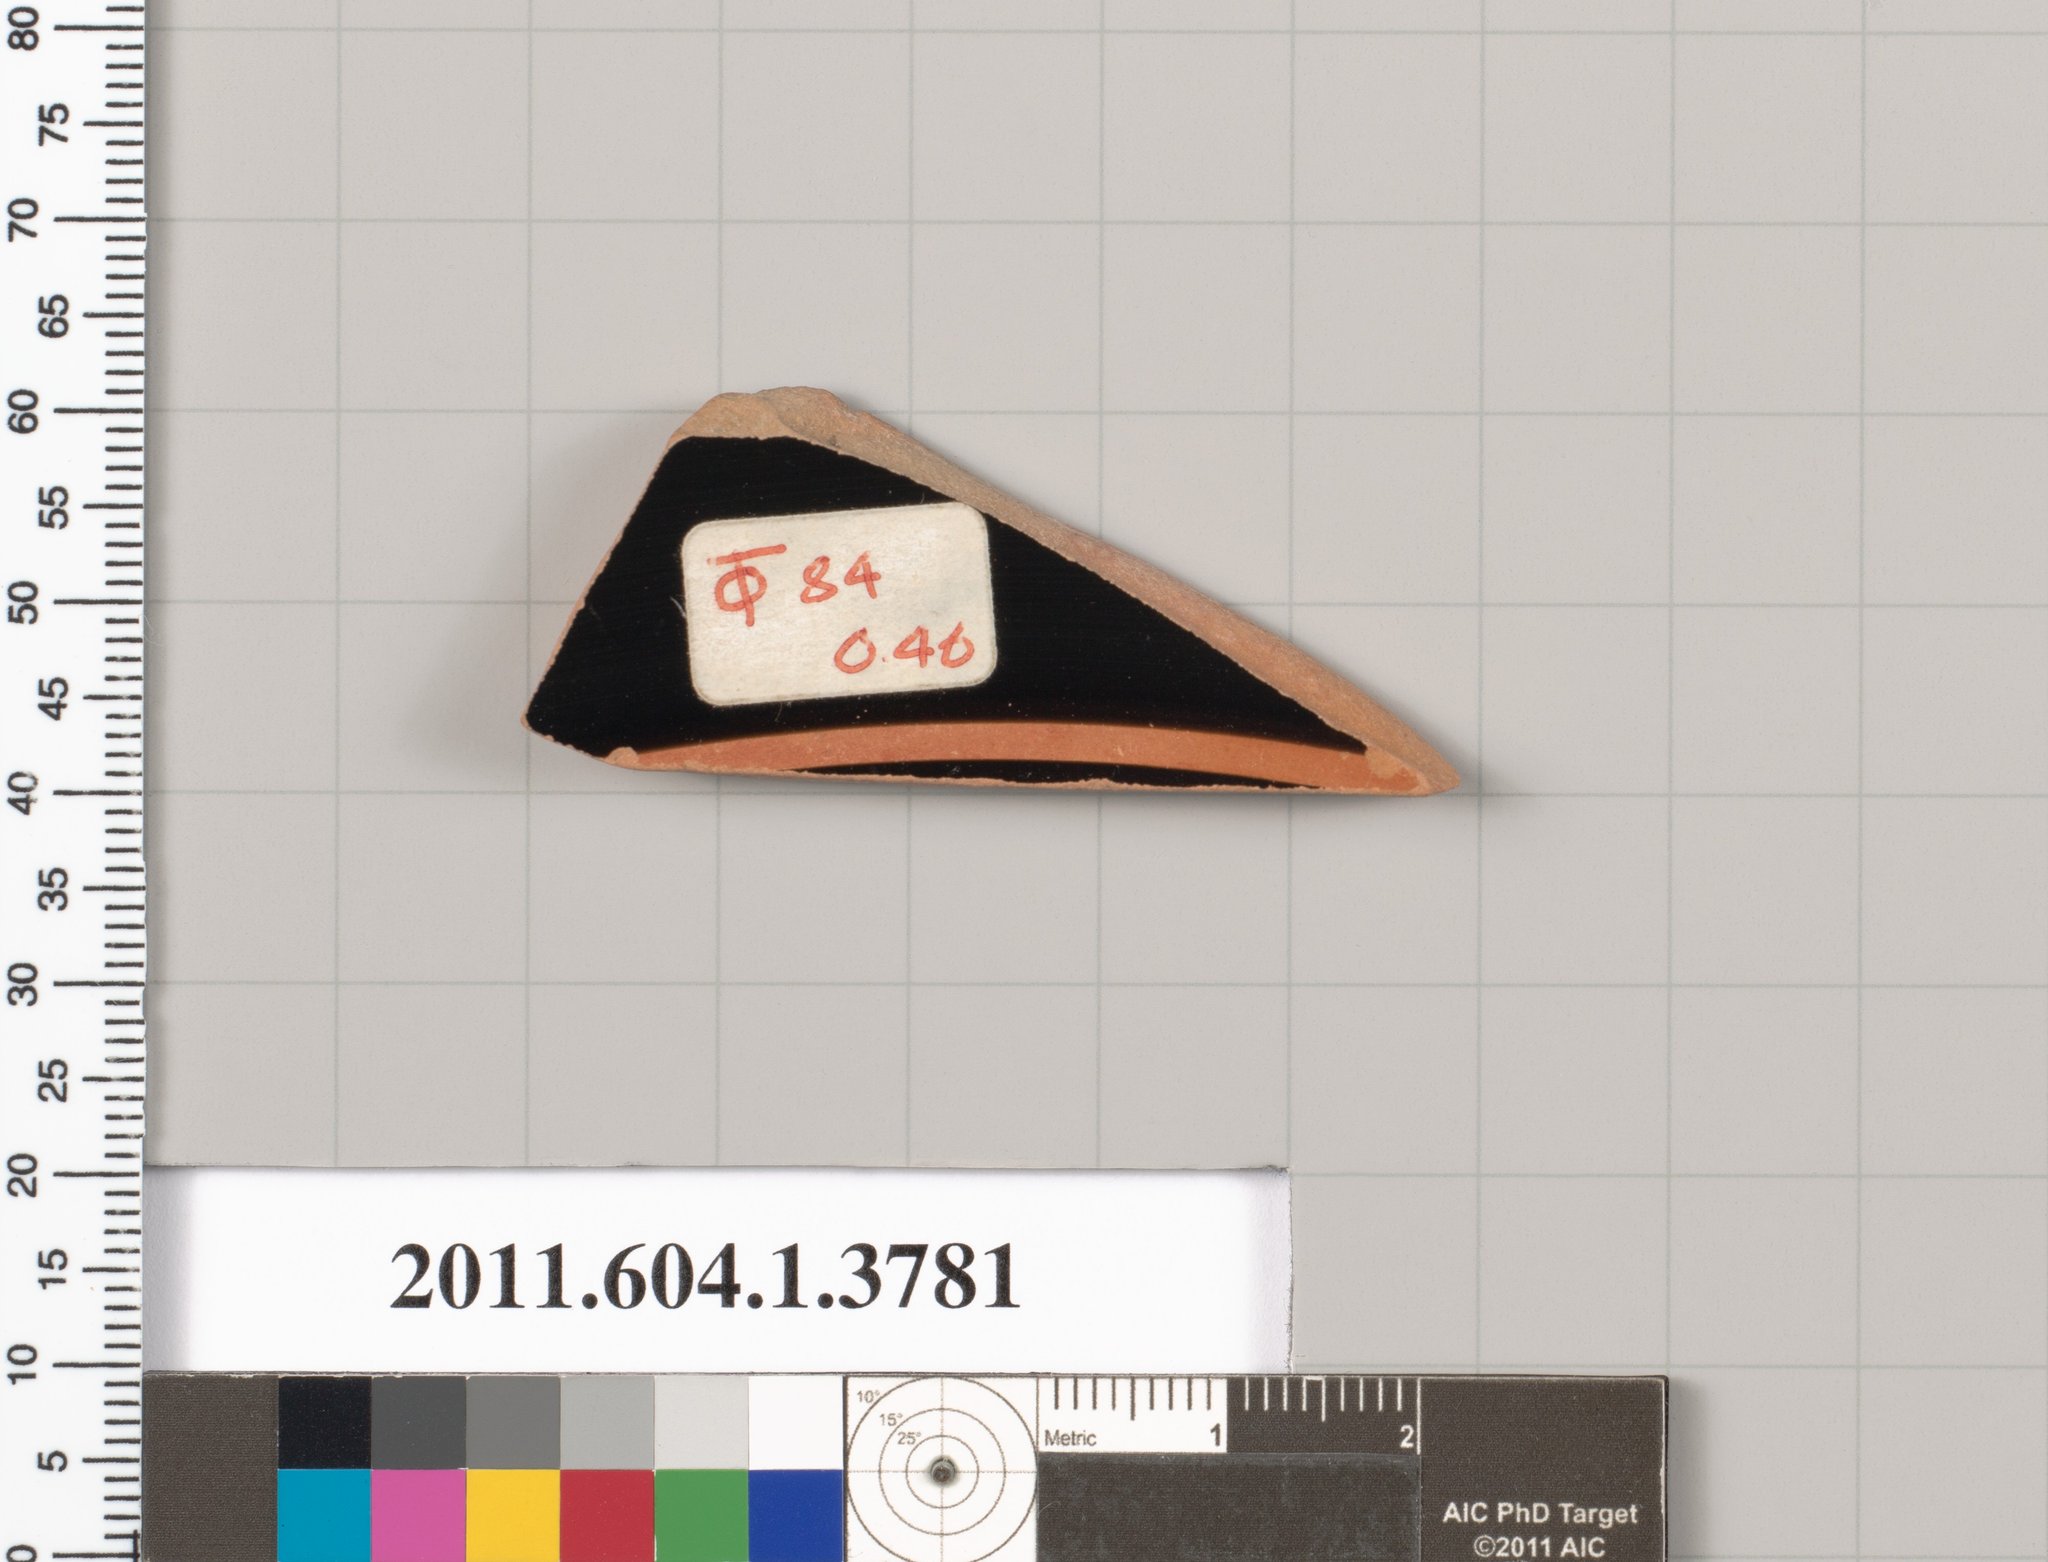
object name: kylix fragment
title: Terracotta fragment of a kylix (drinking cup)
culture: greek, attic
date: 401-450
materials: terracotta